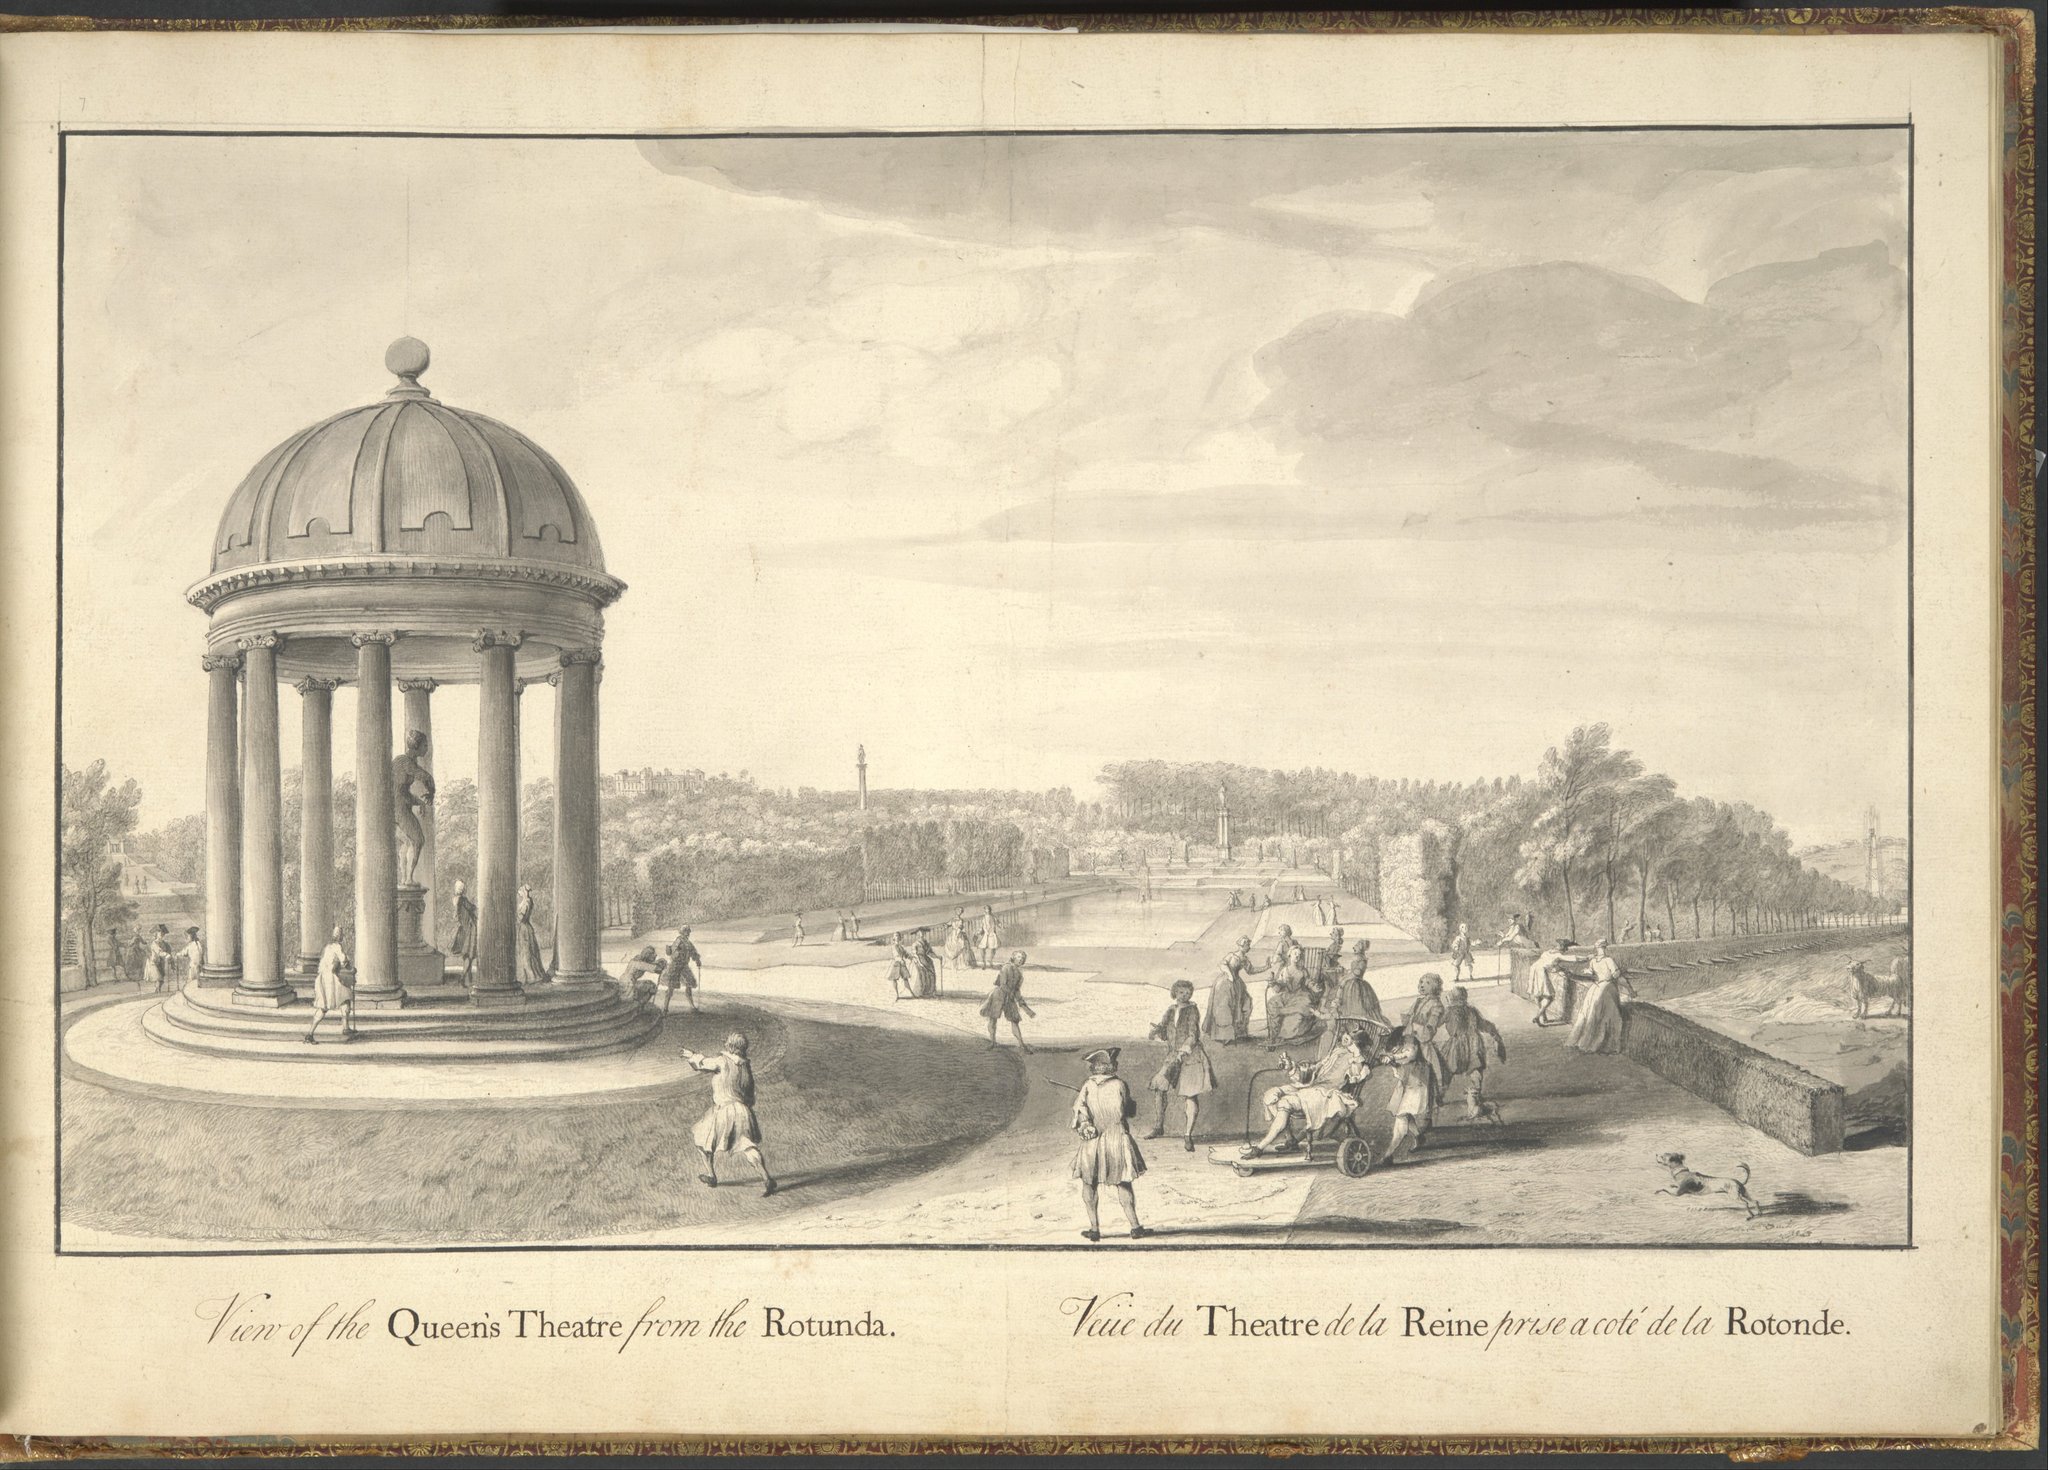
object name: drawing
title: View of the Queen's Theatre from the Rotunda at Stowe, Buckinghamshire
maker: jacques rigaud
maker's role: artist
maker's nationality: french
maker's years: 1681-1754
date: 1733-1734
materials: ink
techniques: brush, pen, wash